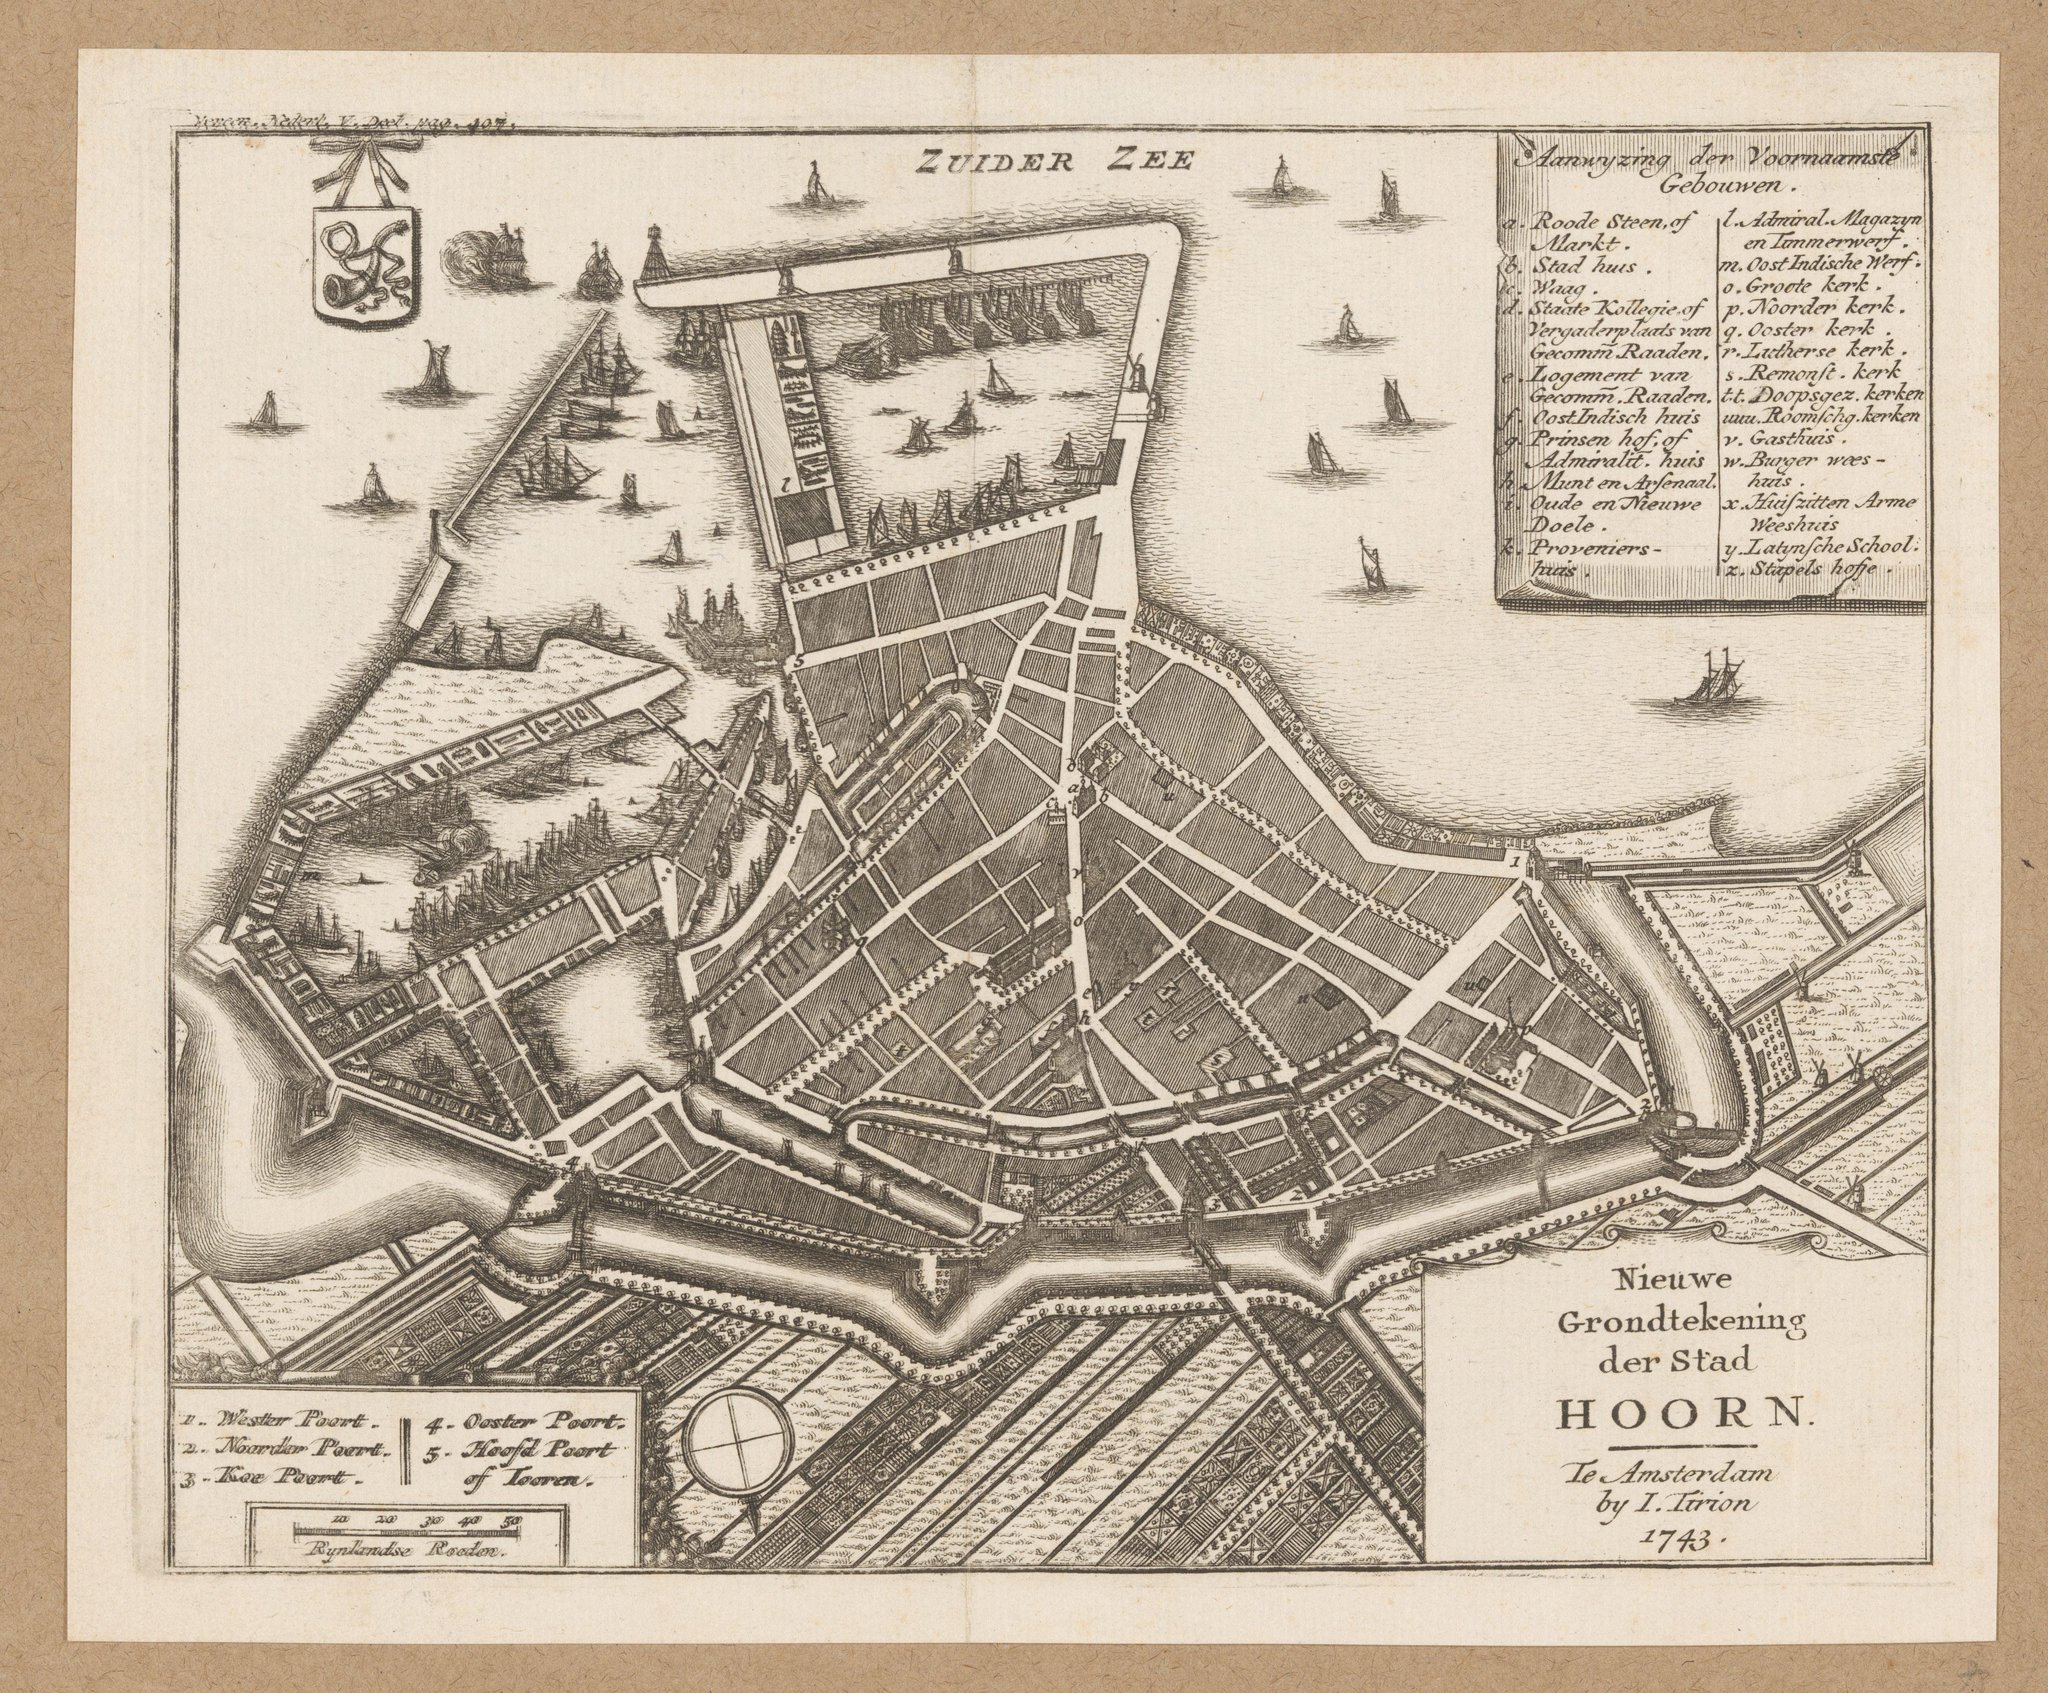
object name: area plan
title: Plattegrond van de stad Hoorn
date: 1743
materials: paper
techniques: engraving, etching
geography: amsterdam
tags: maps of cities, hoorn (north holland)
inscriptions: date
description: Prent uit: Wagenaar, Jan. Tegenwoordige staat der Vereenigde Nederlanden (...). 21 dln. Amsterdam: Isaak Tirion, 1729-1795, dl. 5, p. 406-407.